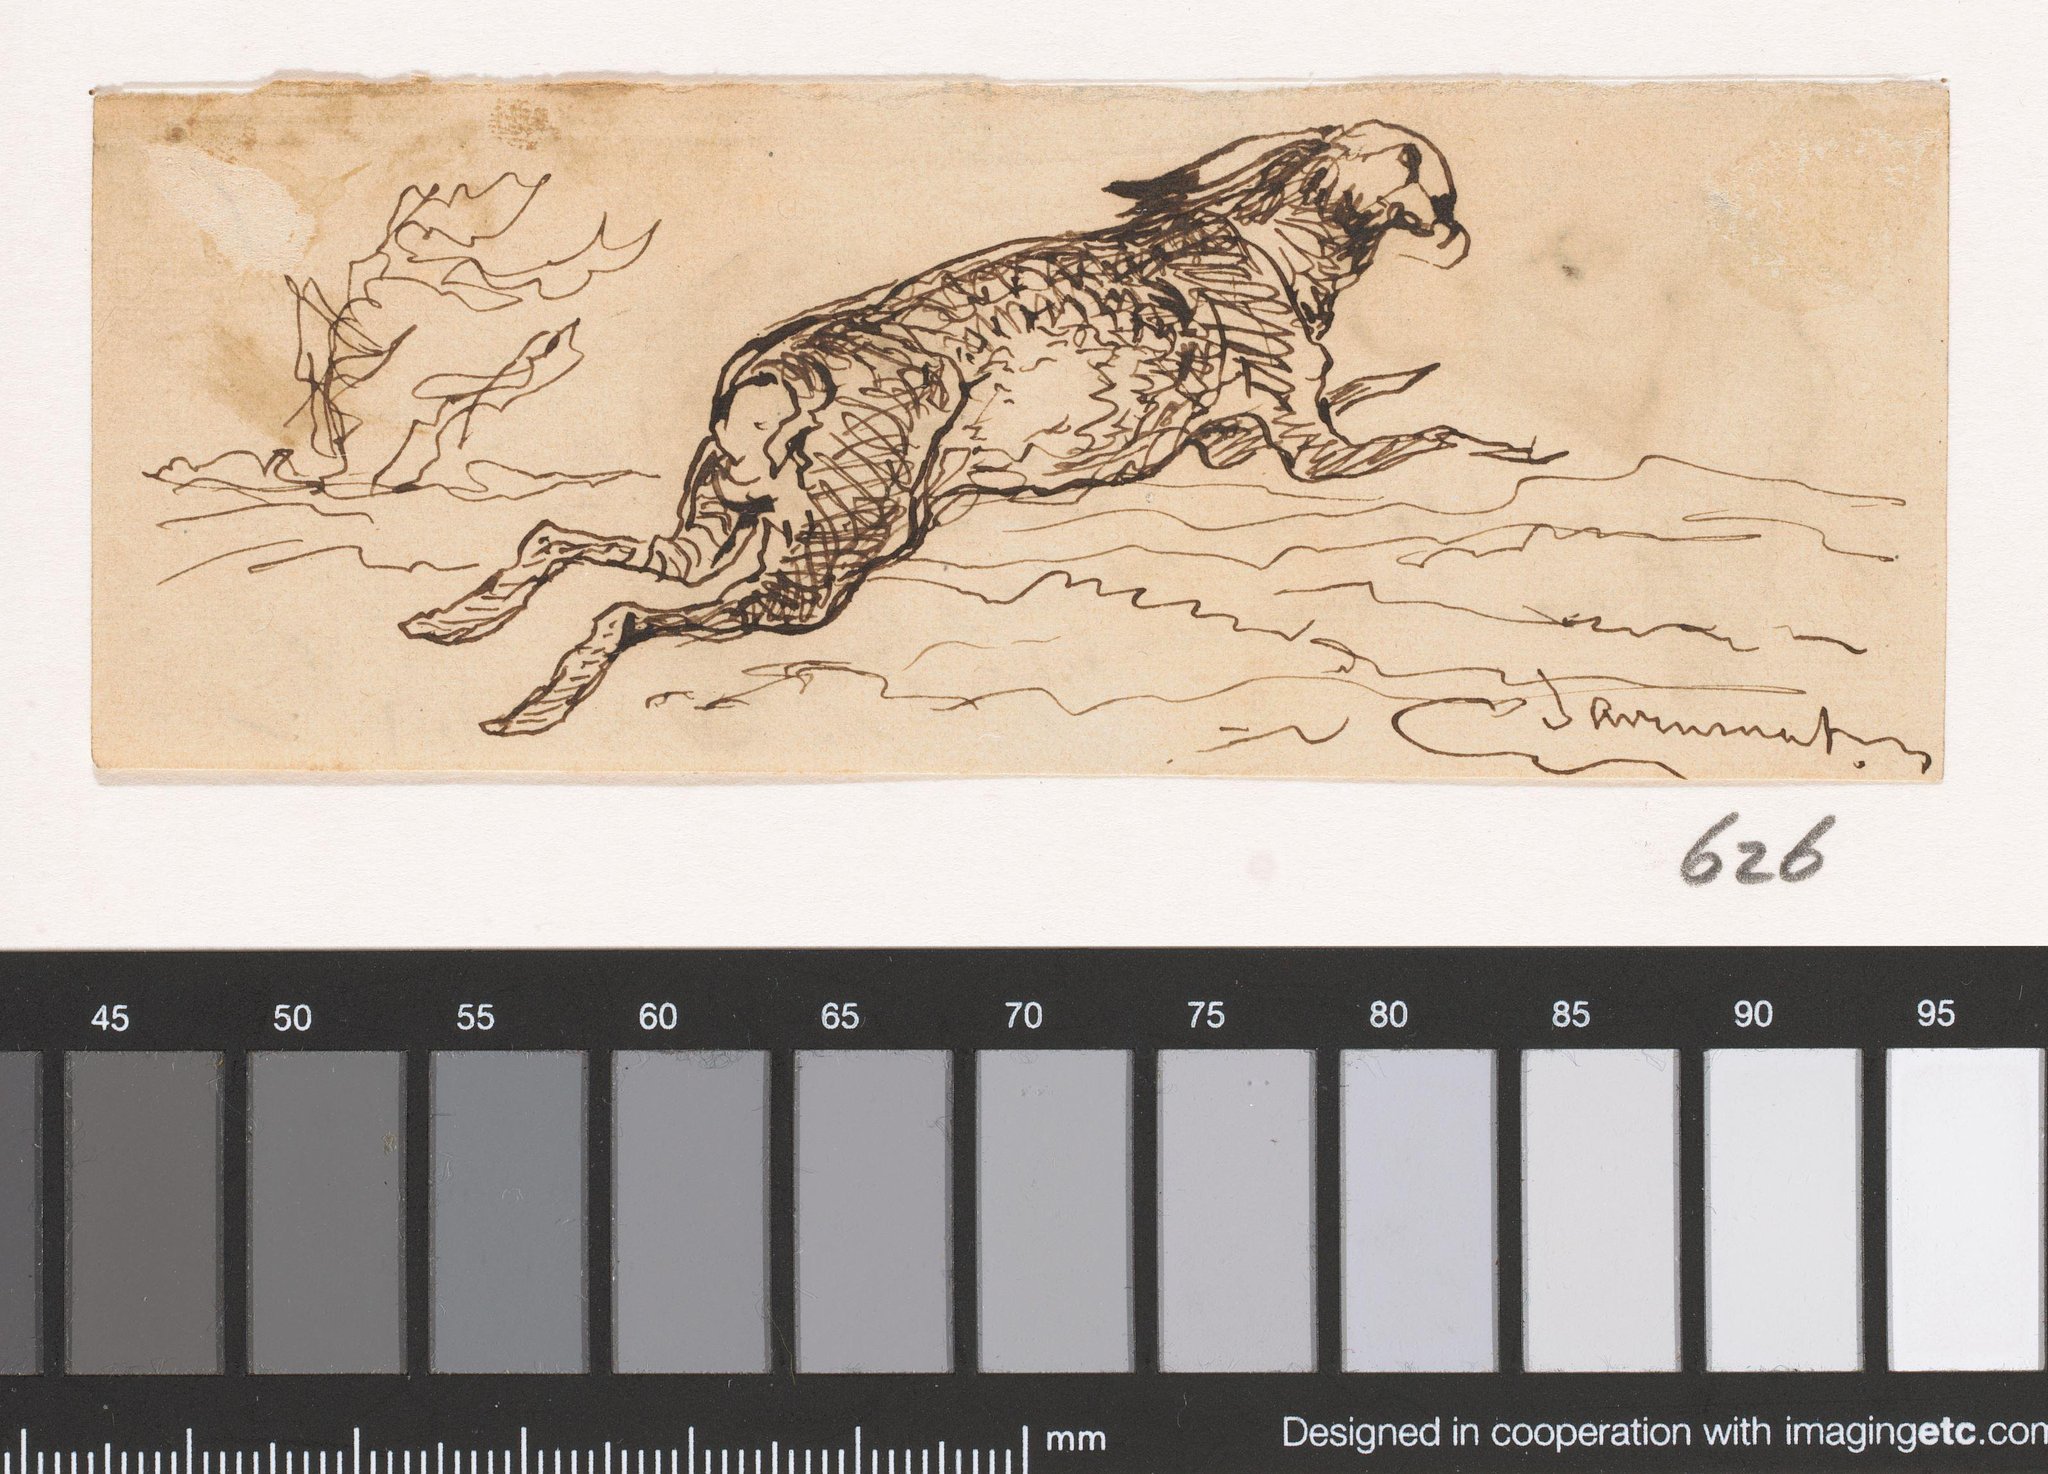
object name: drawing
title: Haas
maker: johannes tavenraat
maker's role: draughtsman, painter, print maker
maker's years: 1809-1881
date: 1869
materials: ink, paper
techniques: pen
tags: rodents: hare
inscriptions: collector's mark: Lugt 2228, signature: ‘Tavenraat’